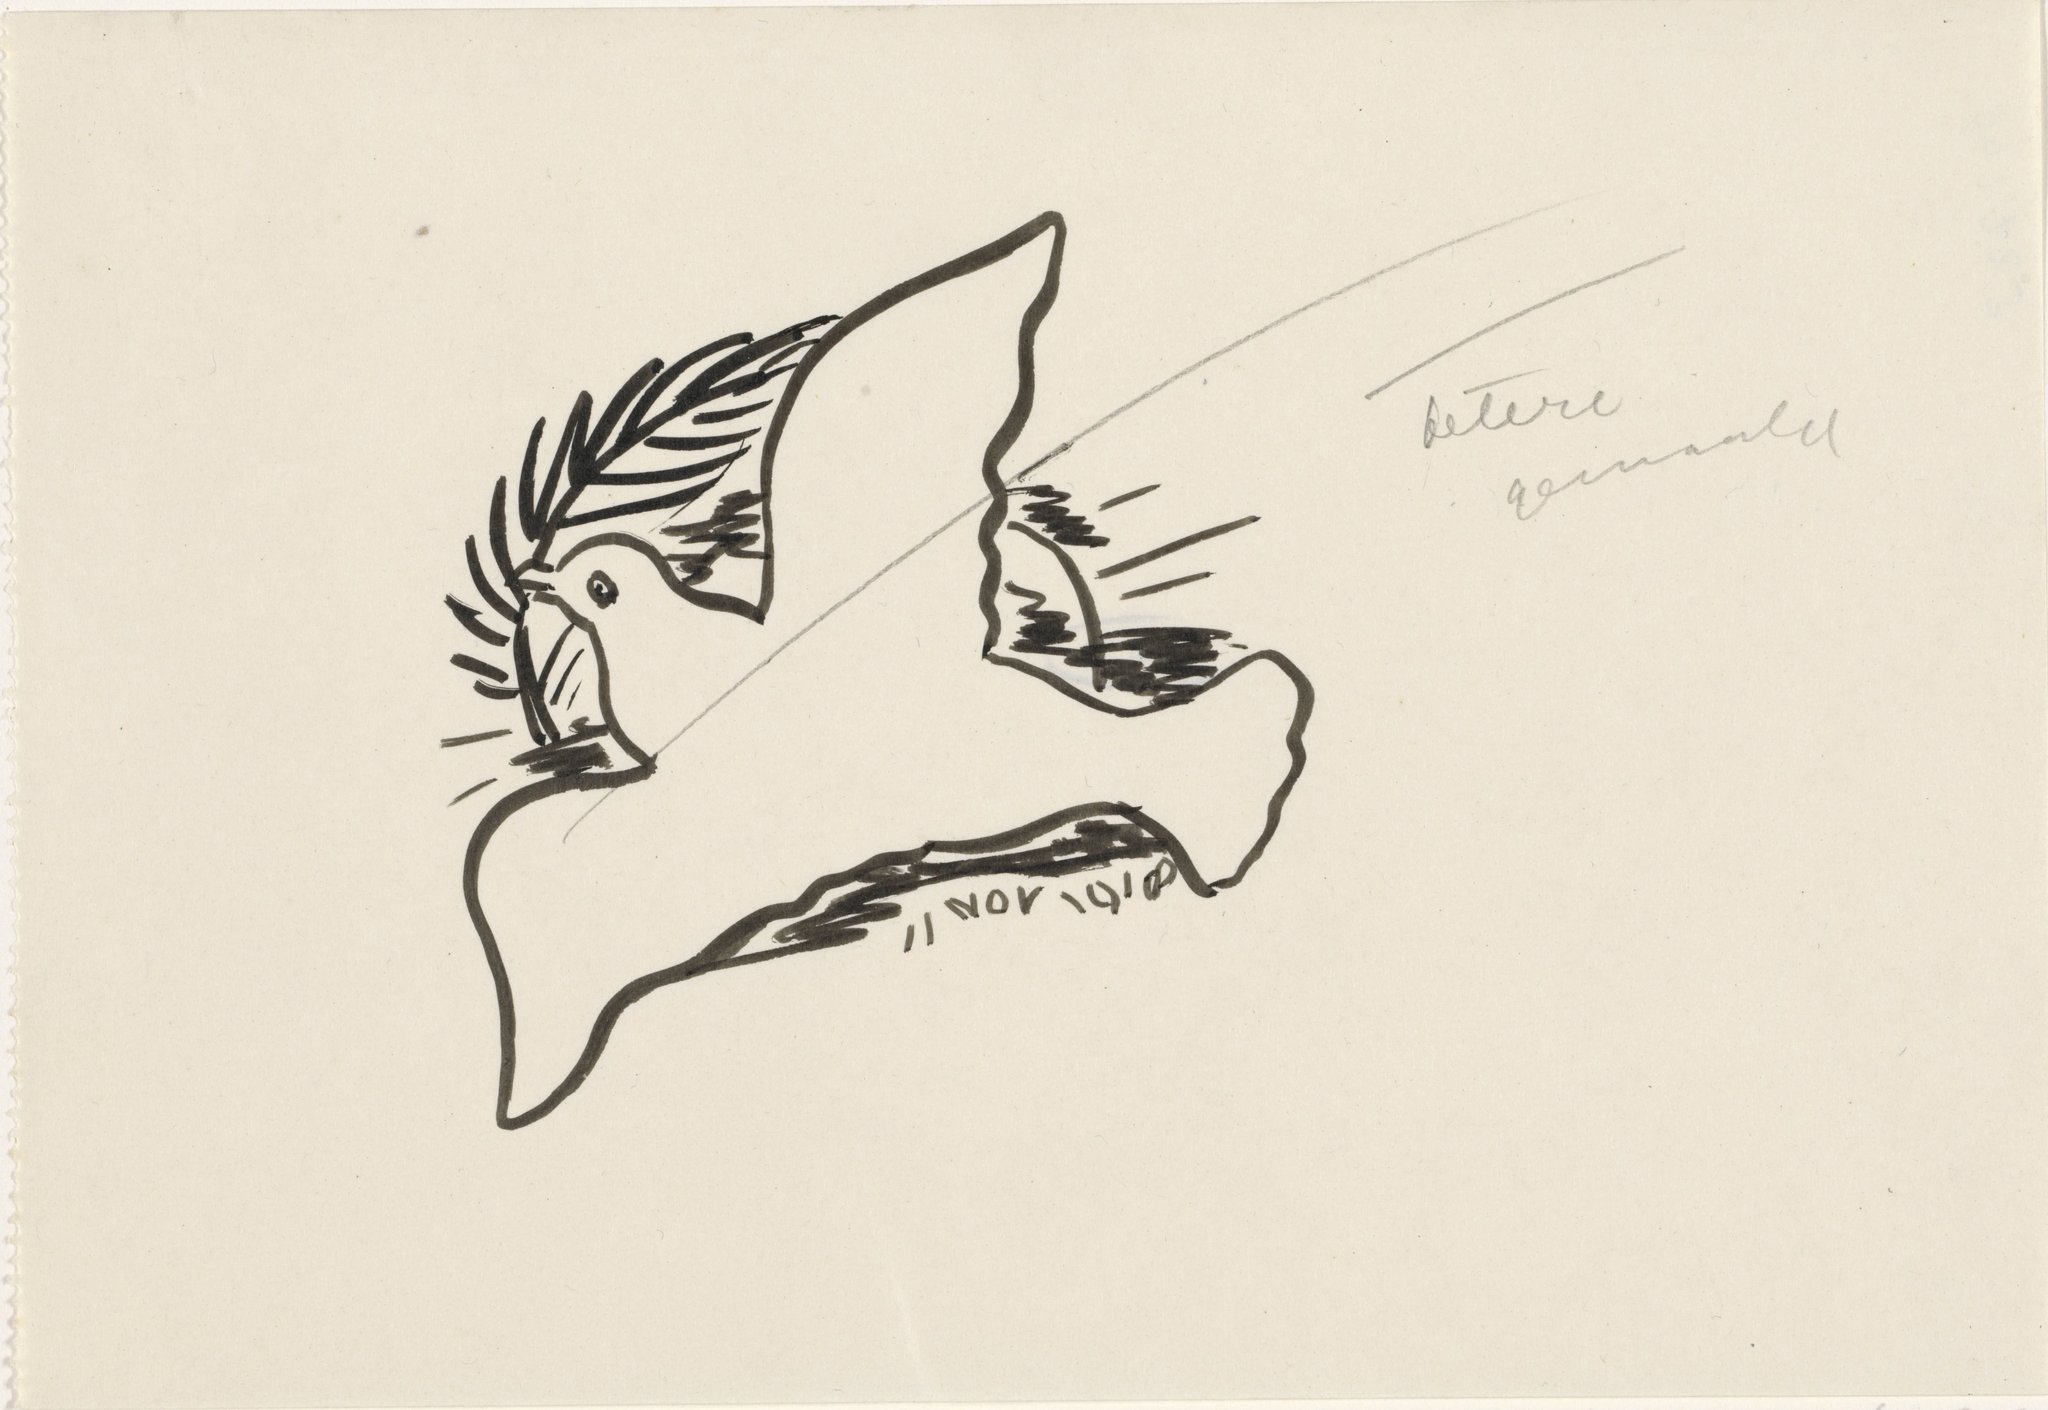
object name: boekillustratie ontwerp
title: Vredesduif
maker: leo gestel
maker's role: draughtsman, print maker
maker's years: 1881-1941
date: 1934-1936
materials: ink, paper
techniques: brush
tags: other birds: dove, (cohen, van anarchist tot monarchist) specific works of literature (with author, title), freedom, liberty; 'libertà' (ripa)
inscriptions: : Lugt 2228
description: Ontwerp voor een boekillustratie voor: Cohen, Alexander. Van anarchist tot monarchist. Amsterdam: De Steenuil, 1936. De kunstenaar heeft bij de tekening vermeld, dat hij een betere tekening van hetzelfde ontwerp heeft gemaakt. De kunstenaar heeft bij de tekening vermeld, dat hij een betere tekening van hetzelfde ontwerp heeft gemaakt.